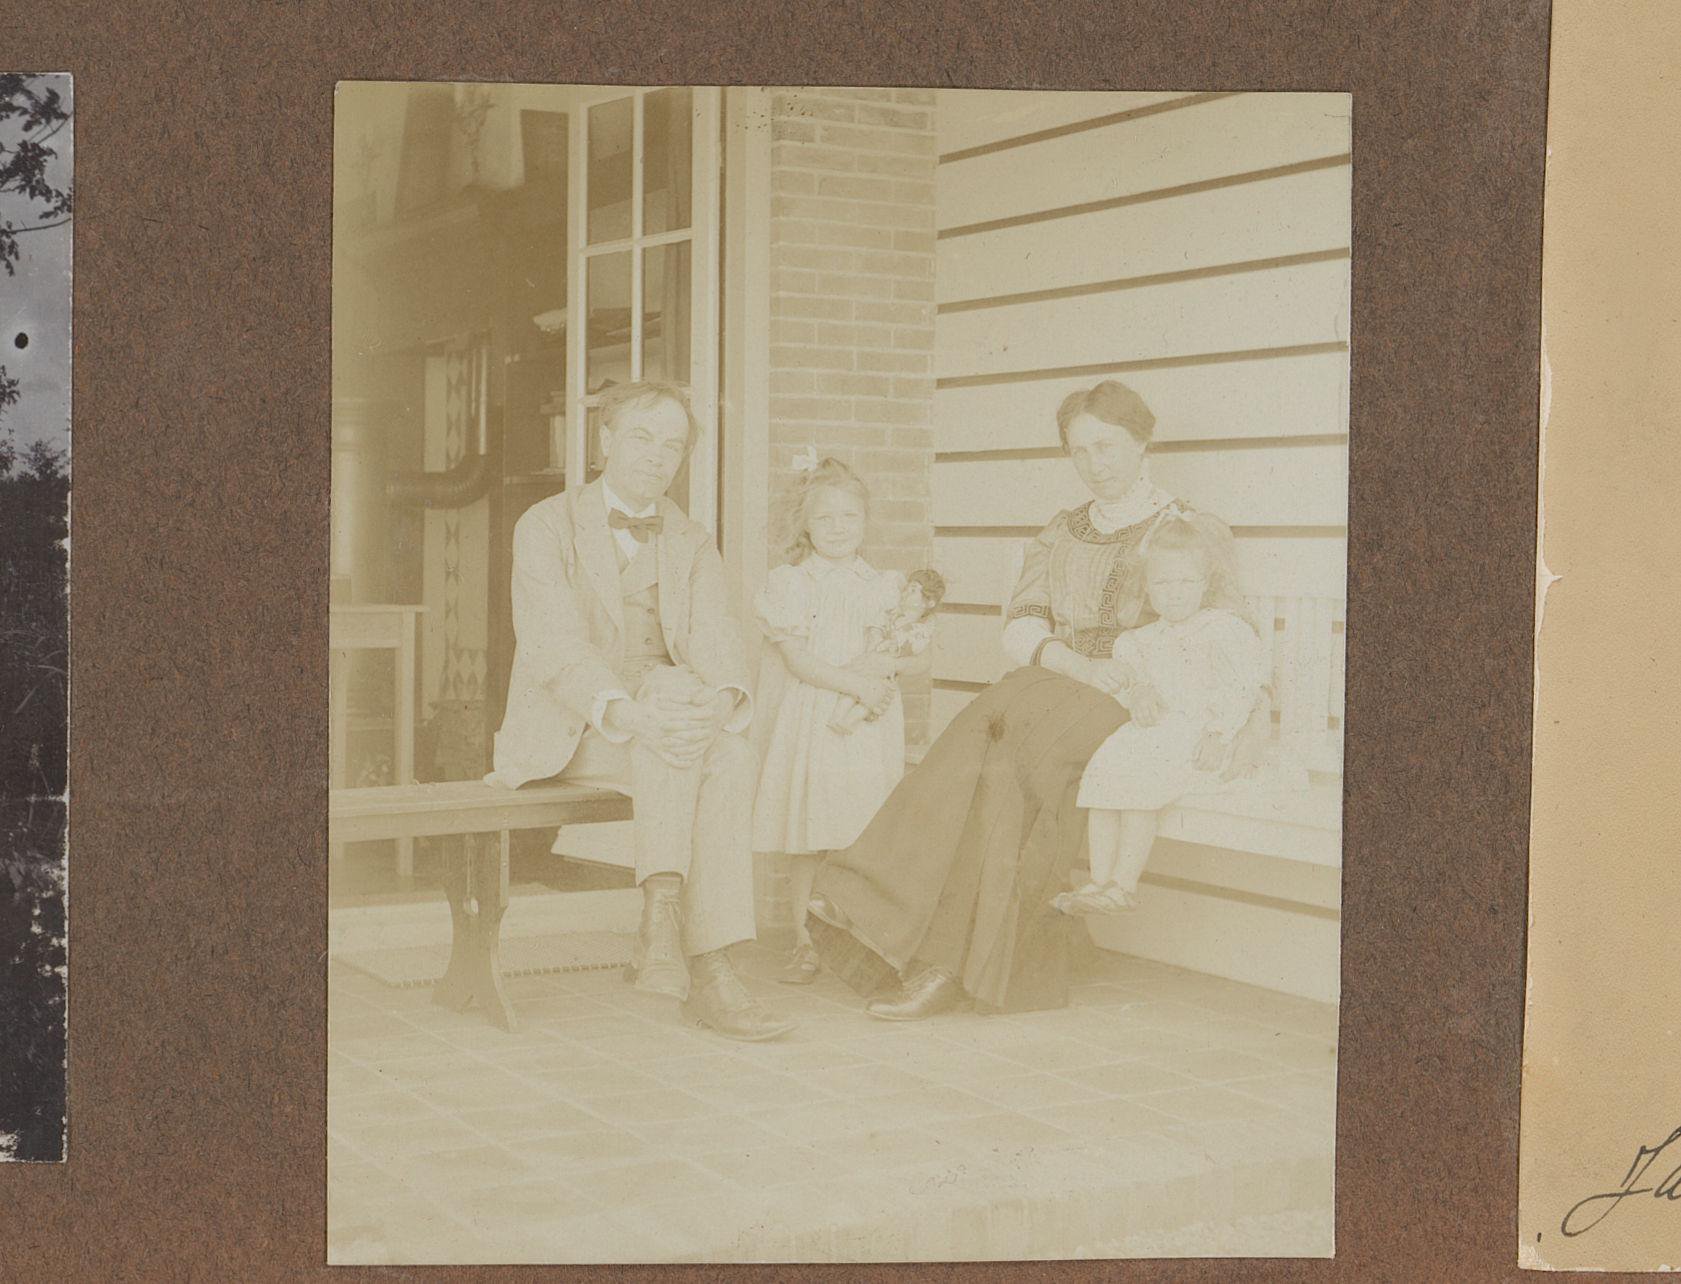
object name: photograph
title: Alphons Diepenbrock met vrouw en twee dochters, Holtwiek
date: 1911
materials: photographic support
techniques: photography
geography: amsterdam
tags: amsterdam, alphons diepenbrock, jonkvrouw wilhelmina elisabeth petronella cornelia de jong van beek en donk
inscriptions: date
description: Foto op bruin albumblad 3 van familiealbum van Alphons Diepenbrock.